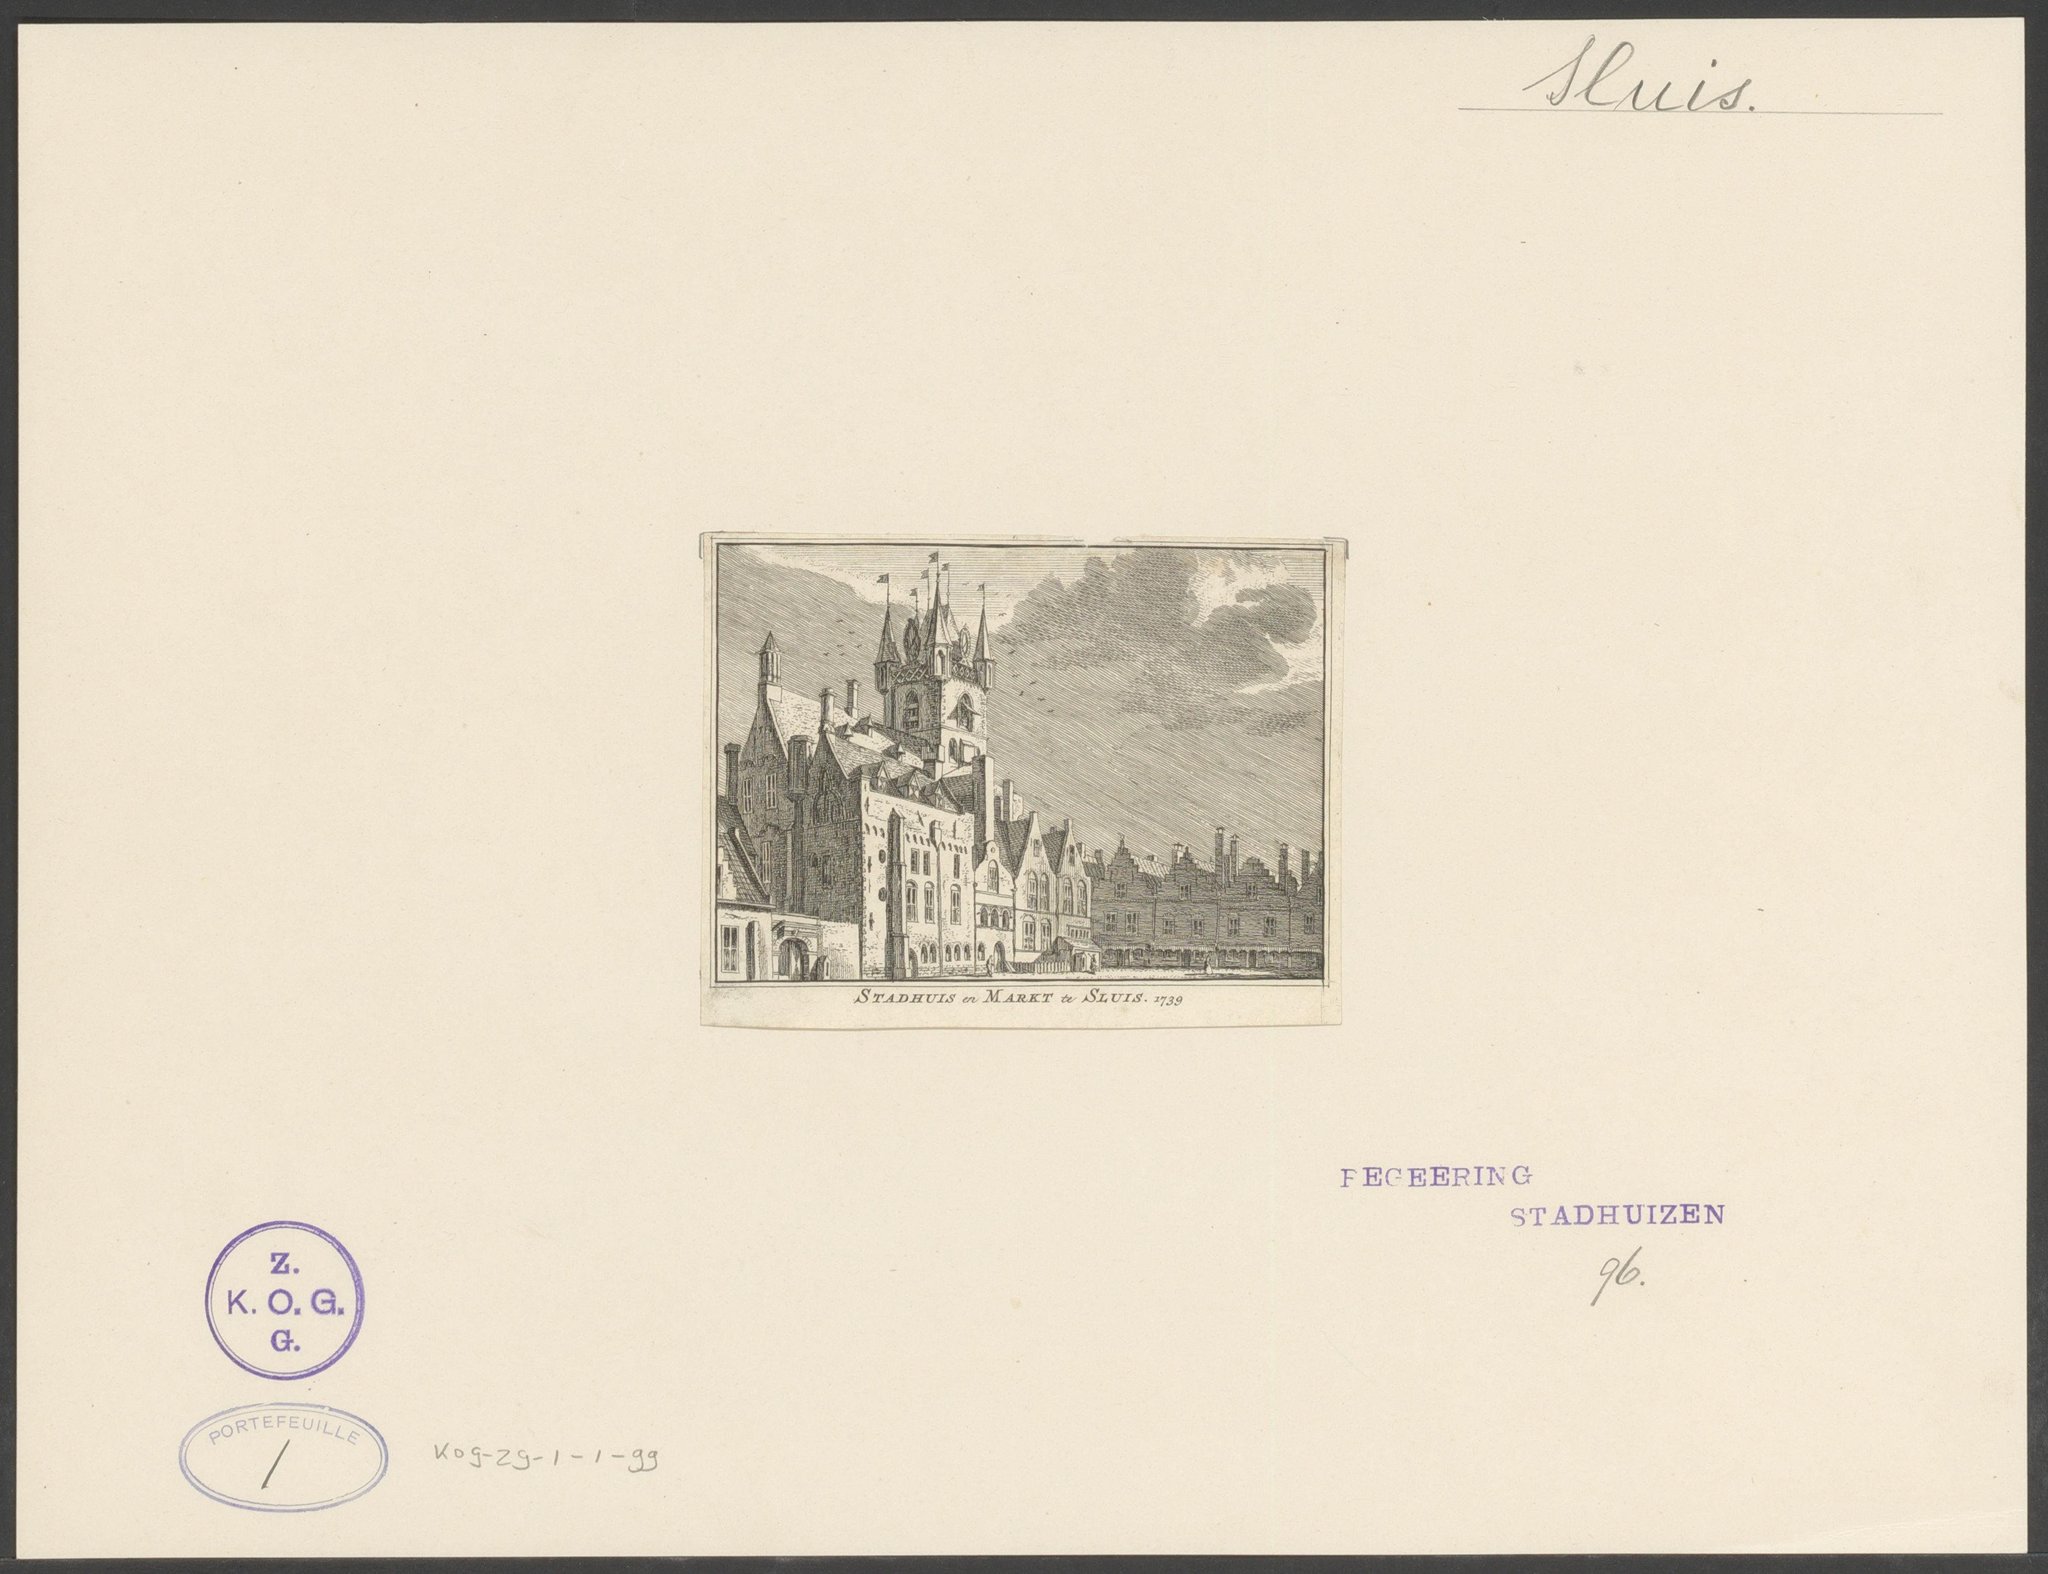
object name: print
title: Stadhuis en Markt te Sluis. 1739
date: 1745-1746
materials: paper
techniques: etching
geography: amsterdam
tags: townhall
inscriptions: collector's mark: Lugt 1641, collector's mark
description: Prent eerst gebruikt in: Het verheerlykt Nederland of kabinet van hedendaagsche gezigten van steden, dorpen […]. 9 delen. Amsterdam: Isaak Tirion en weduwe Isaak Tirion, 1745-1774, dl. 2 (1746), ill. 171-172. Later in: Nederlandsche tafereelen; of eene keurige verzameling van negen honderd fraaije gezigten van steden, dorpen, sloten, oudheden [….]. 9 delen. Amsterdam: Jan de Groot, 1792, dl. 2, ill. 171-172.